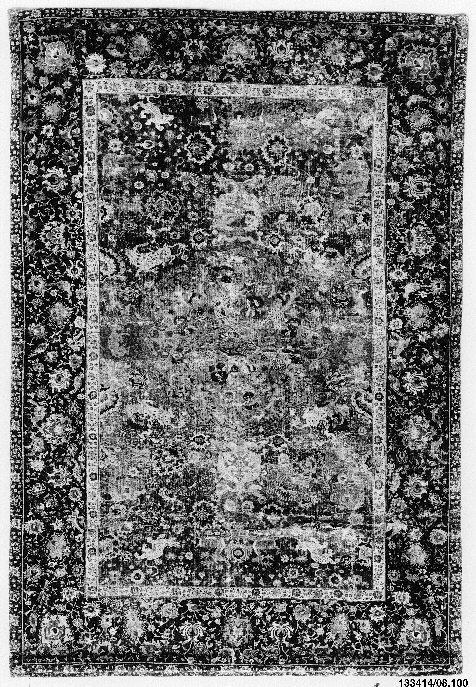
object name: carpet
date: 1551-1600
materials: cotton, silk, wool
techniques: asymmetrically knotted pile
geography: afghanistan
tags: flowers